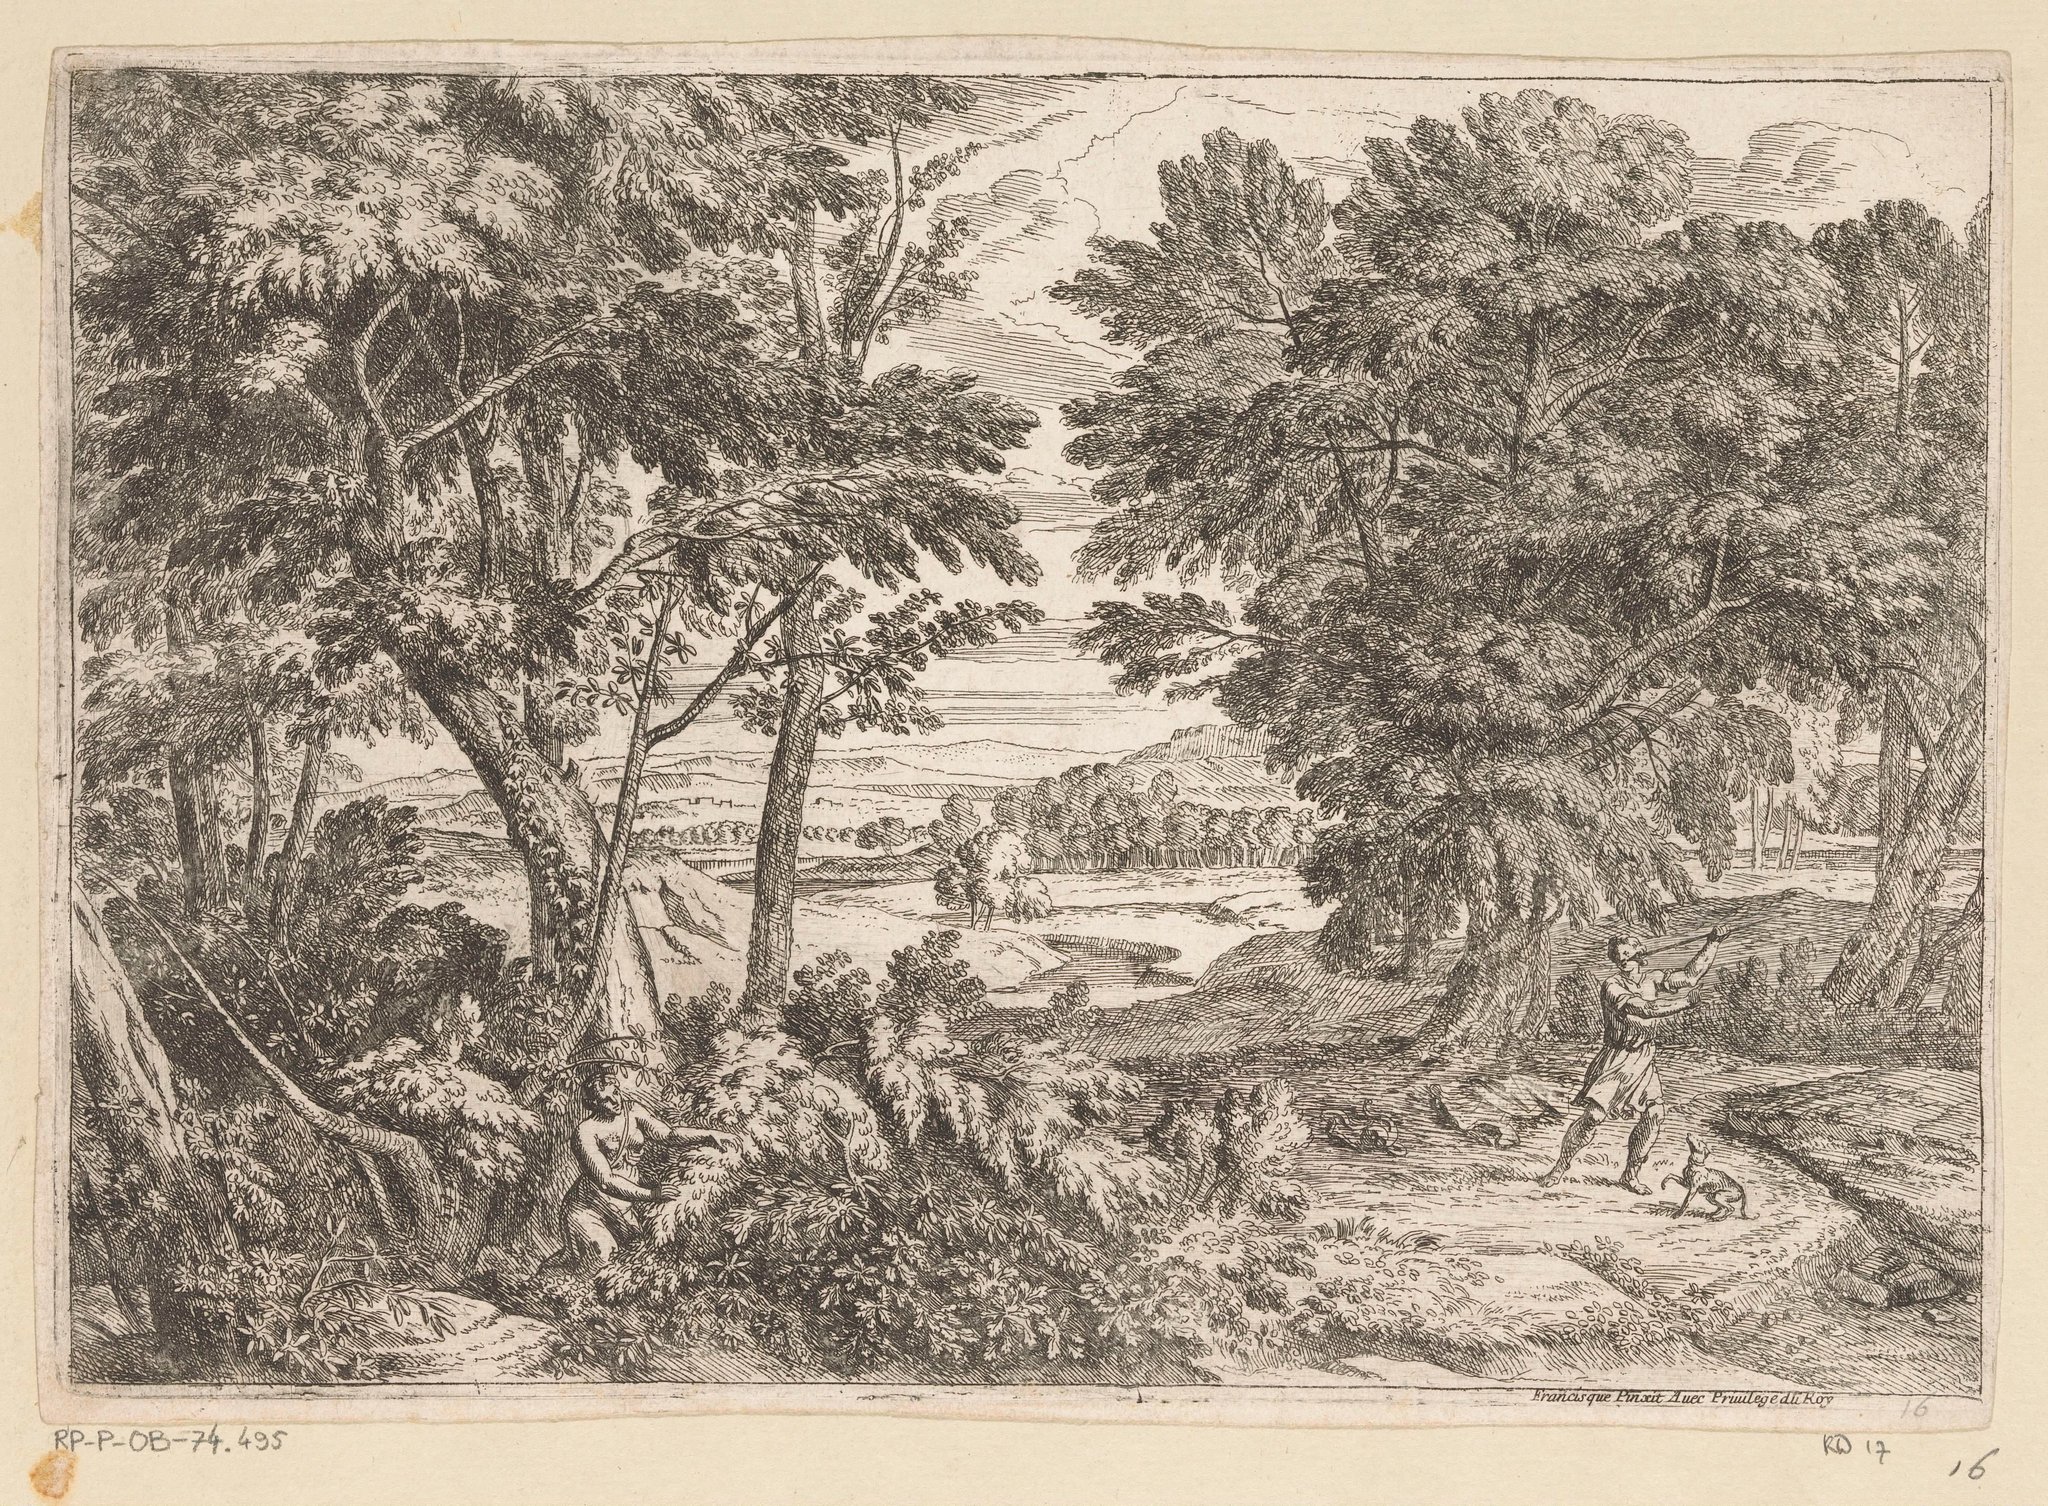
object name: print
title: Arcadisch landschap met Kephalos en Prokris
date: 1690-1730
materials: paper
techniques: etching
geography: france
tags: landscapes in the temperate zone - hh - ideal landscapes, trees, cephalus and procris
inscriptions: collector's mark: Lugt 240